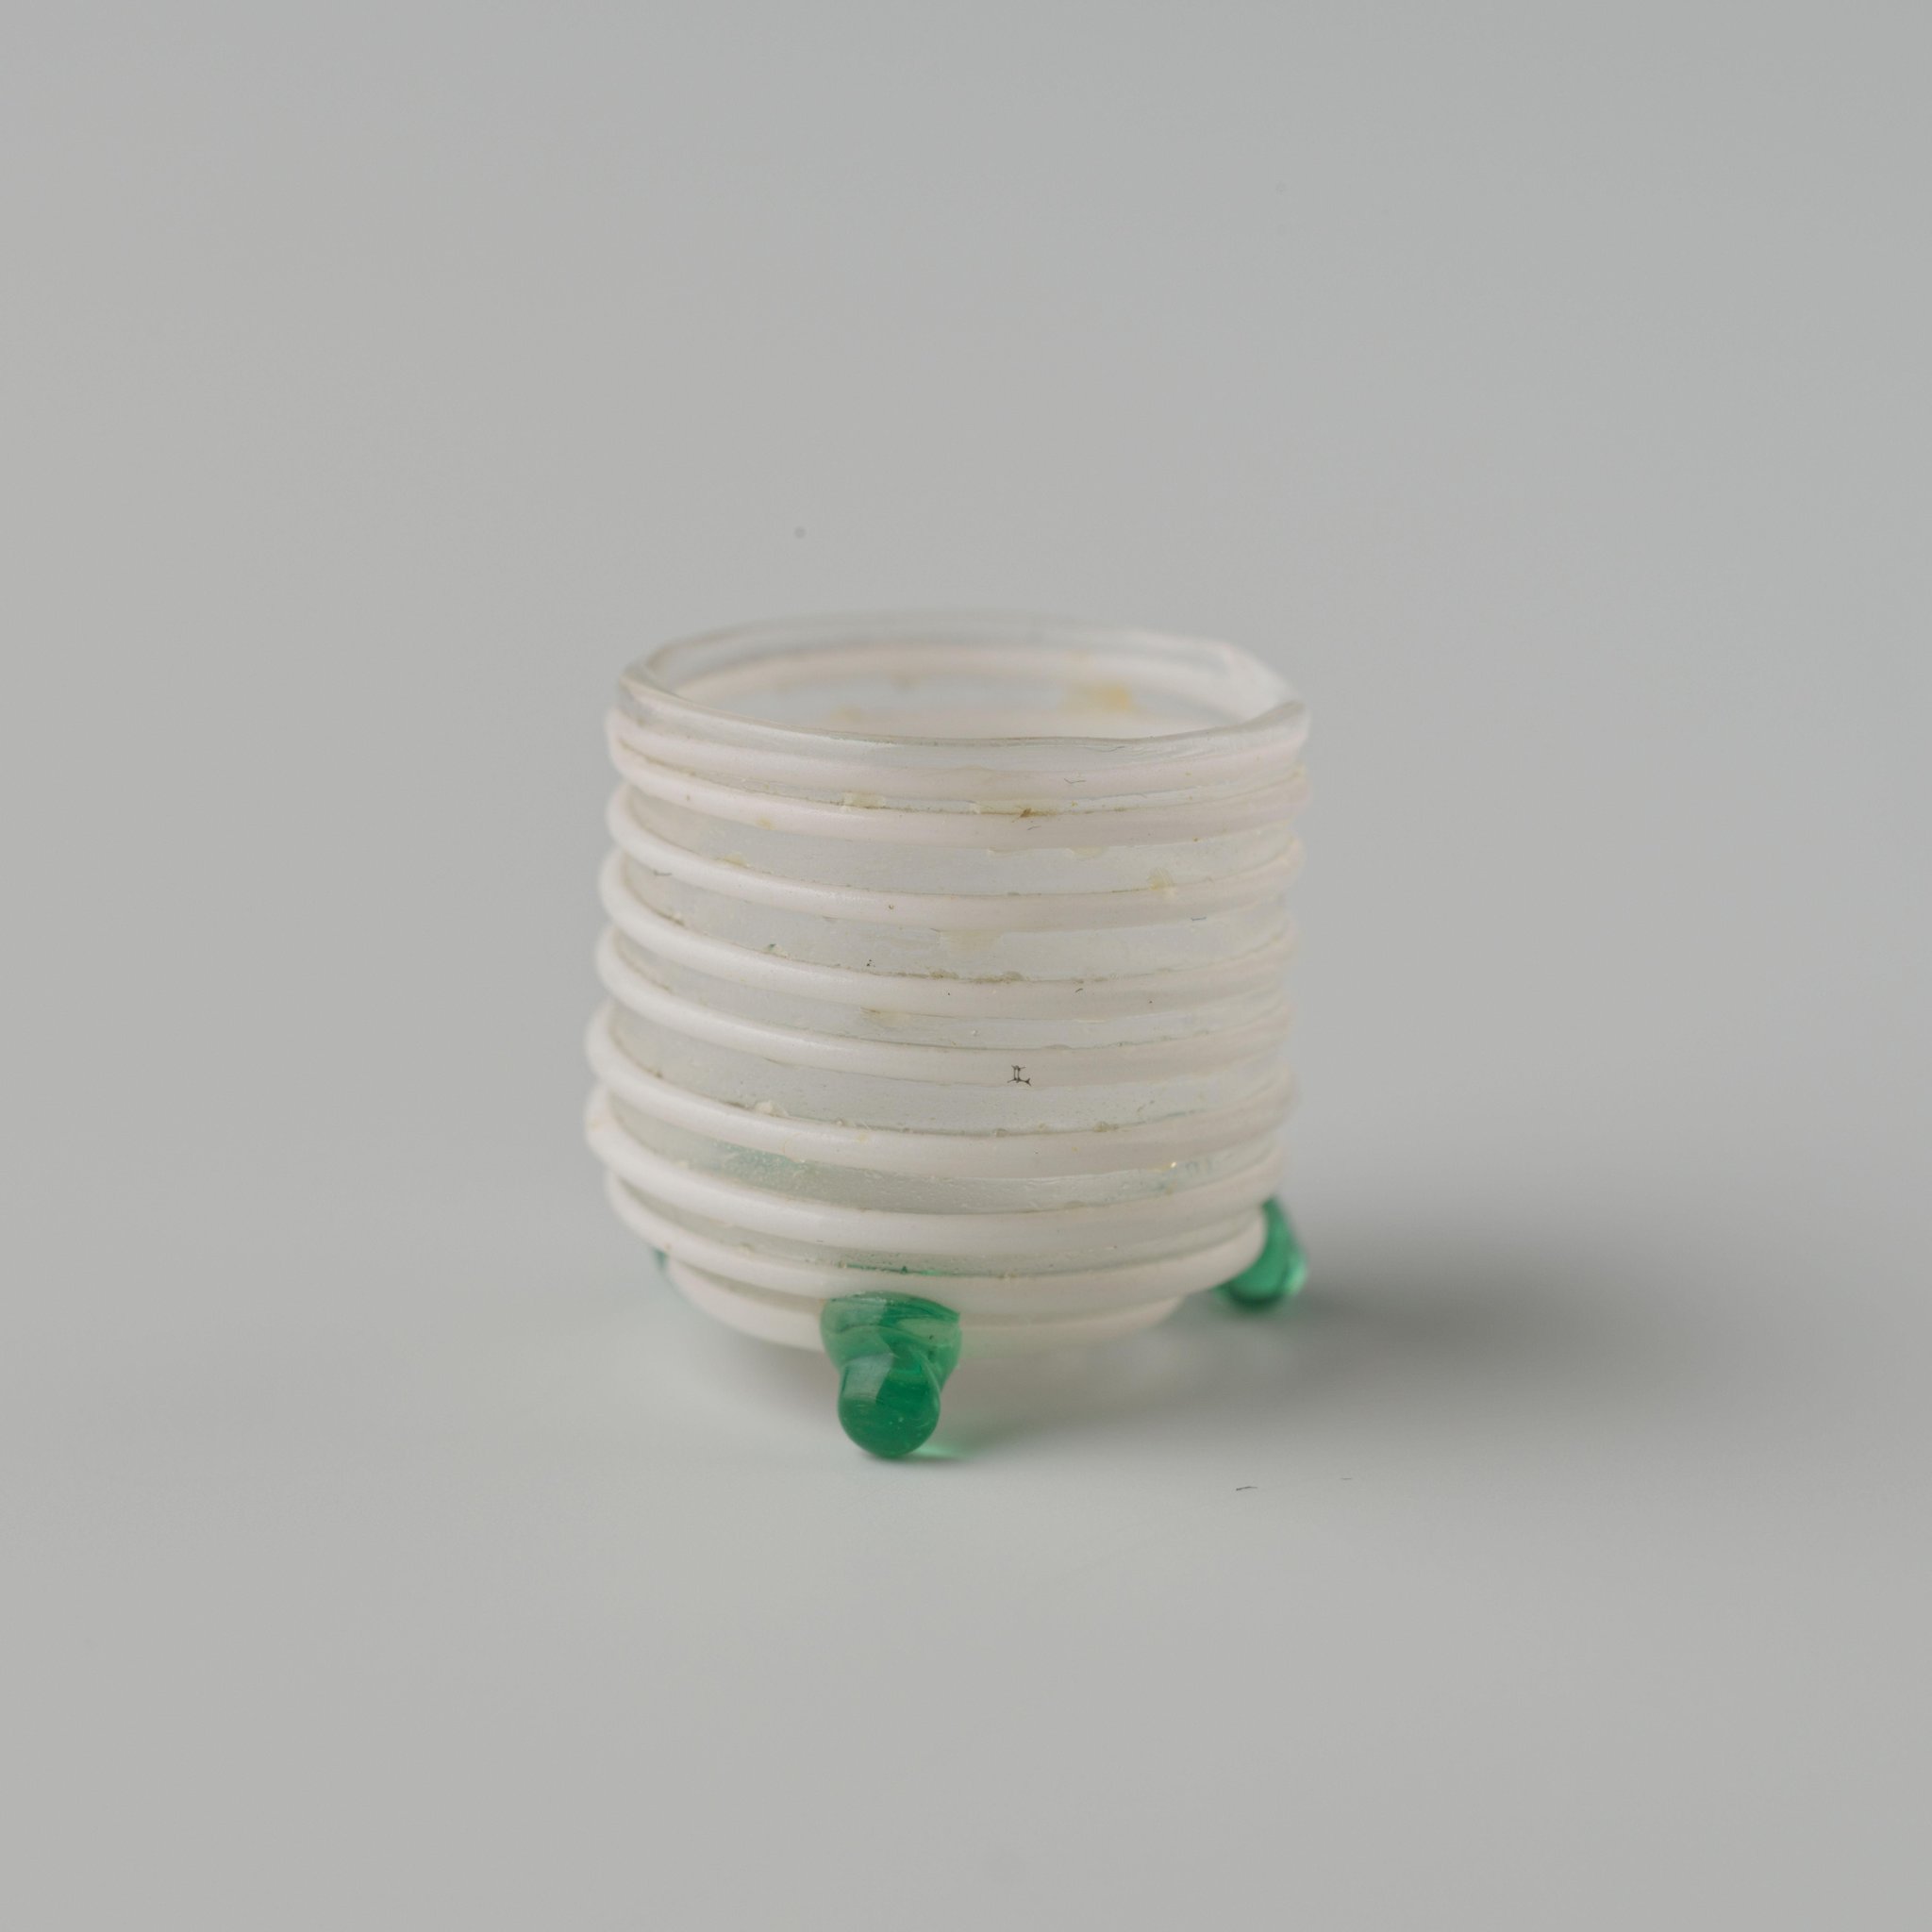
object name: cup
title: Beker van helder kleurloos glas versierd met een witte opgelgde spiraaldraad, staand op drie groene bolpootjes.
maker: Anonymous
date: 1675-1710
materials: glass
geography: amsterdam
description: Beker van helder kleurloos glas versierd met één witte opgelegde spiraaldraad, staand op drie groene bolpootjes.